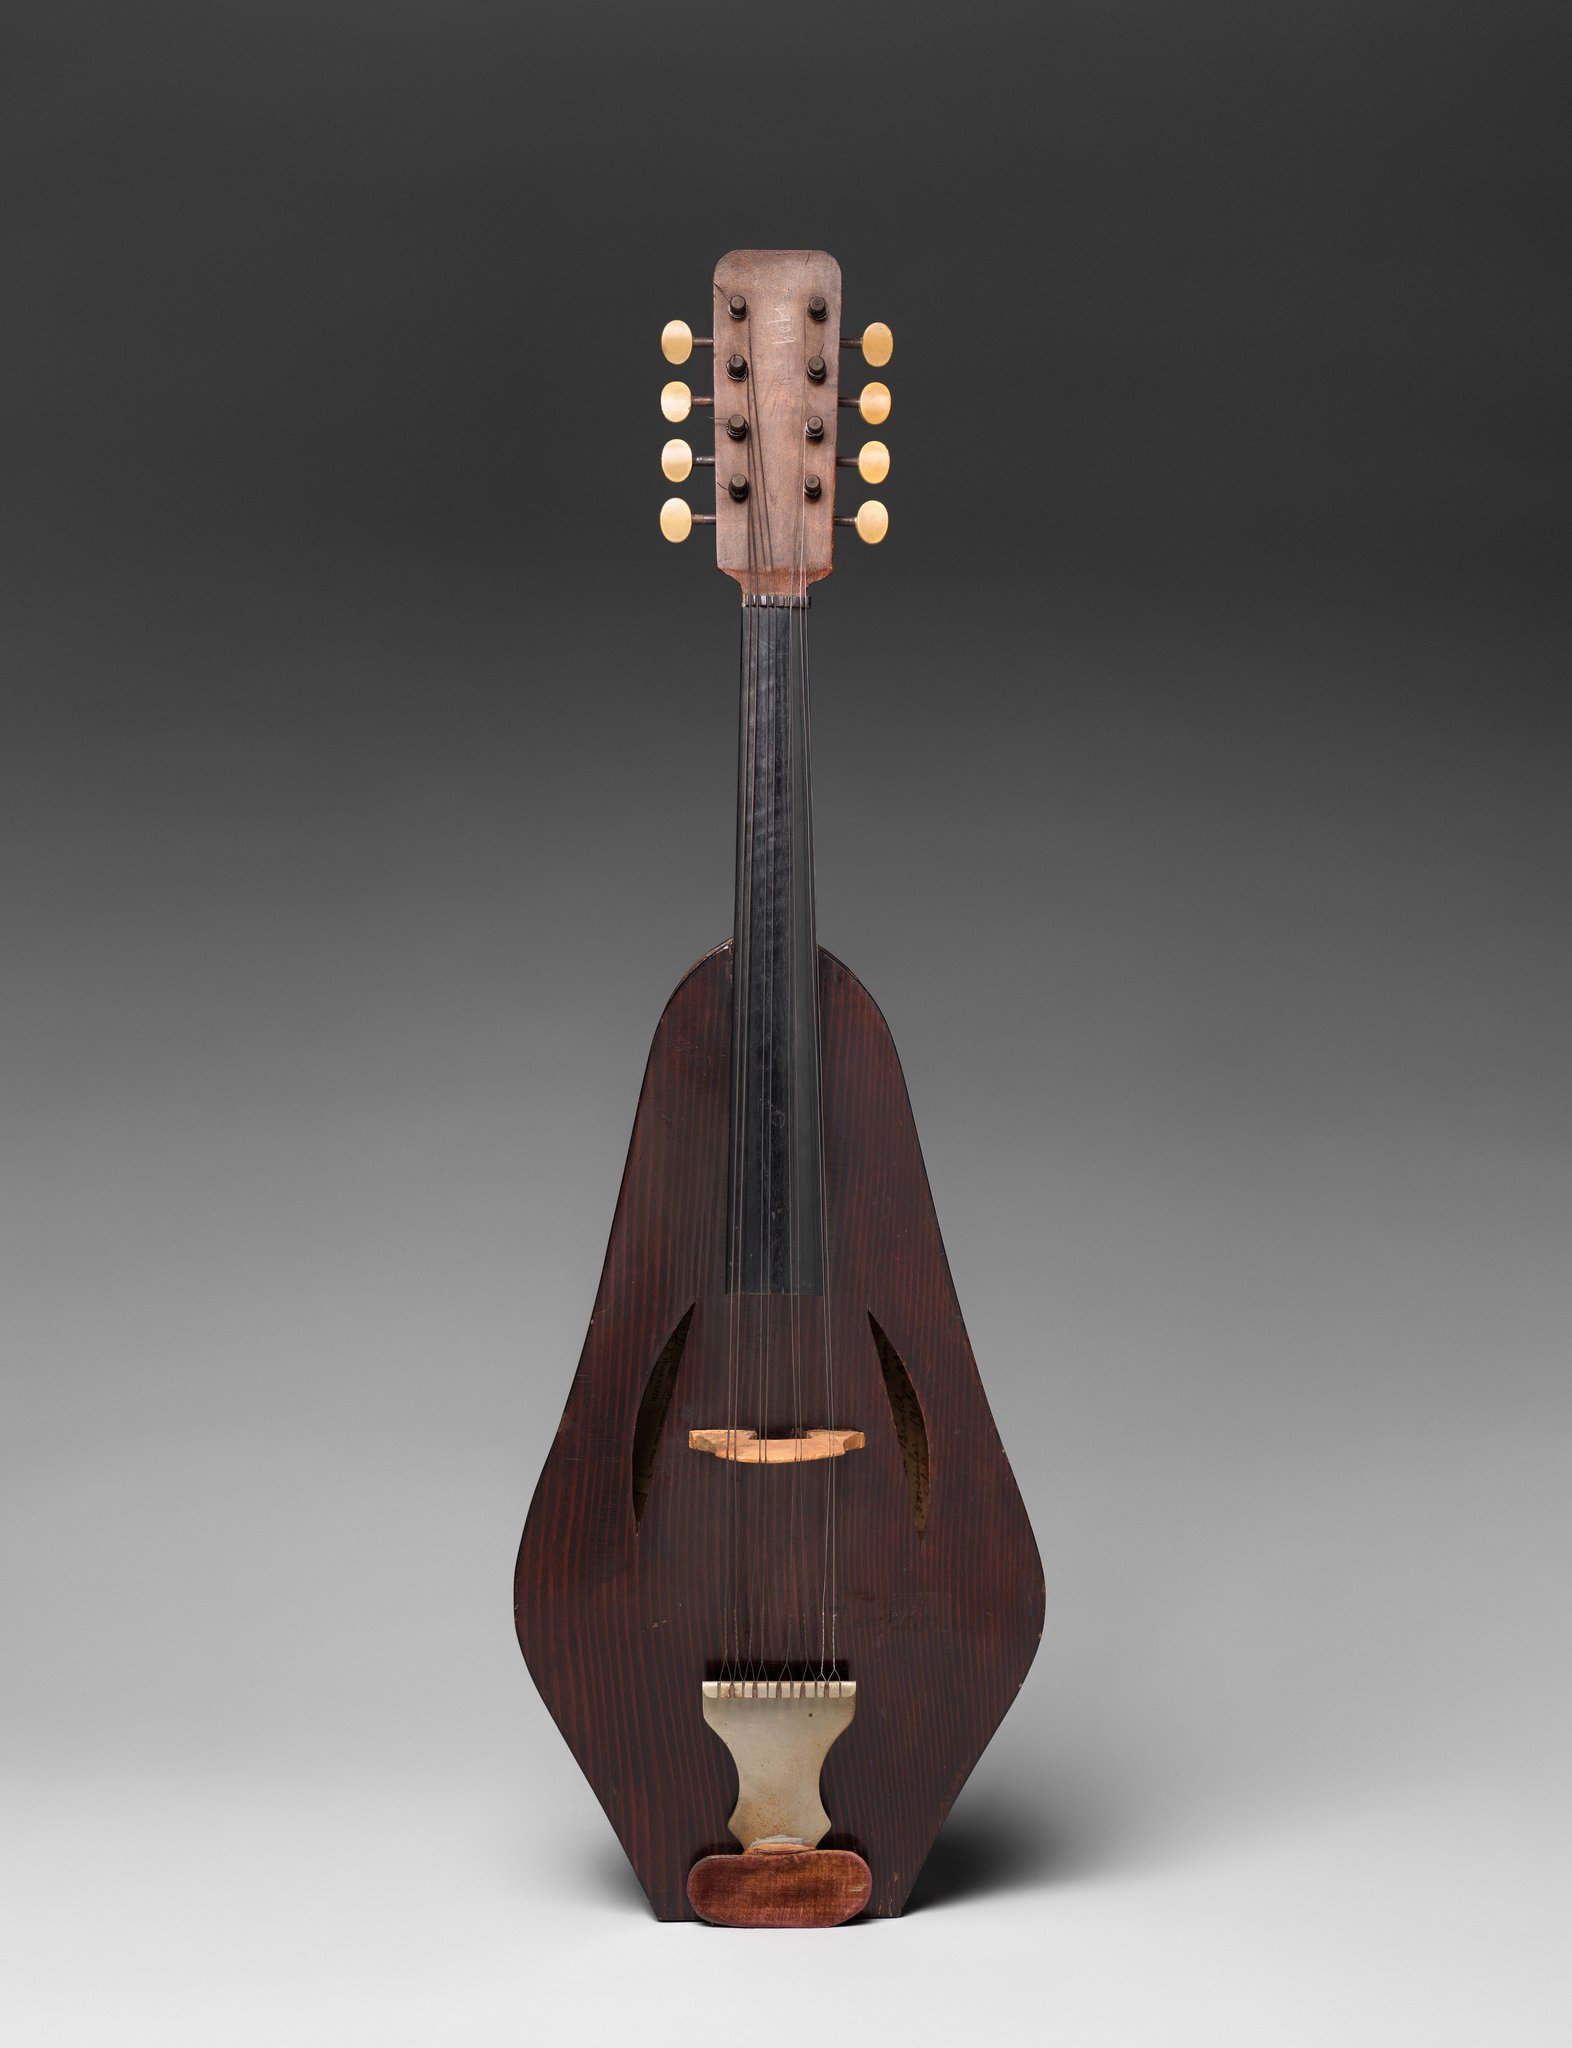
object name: bowed mandolin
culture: north american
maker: joseph collingwood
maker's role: maker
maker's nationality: american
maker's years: 1853-1928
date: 1900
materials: wood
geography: united states